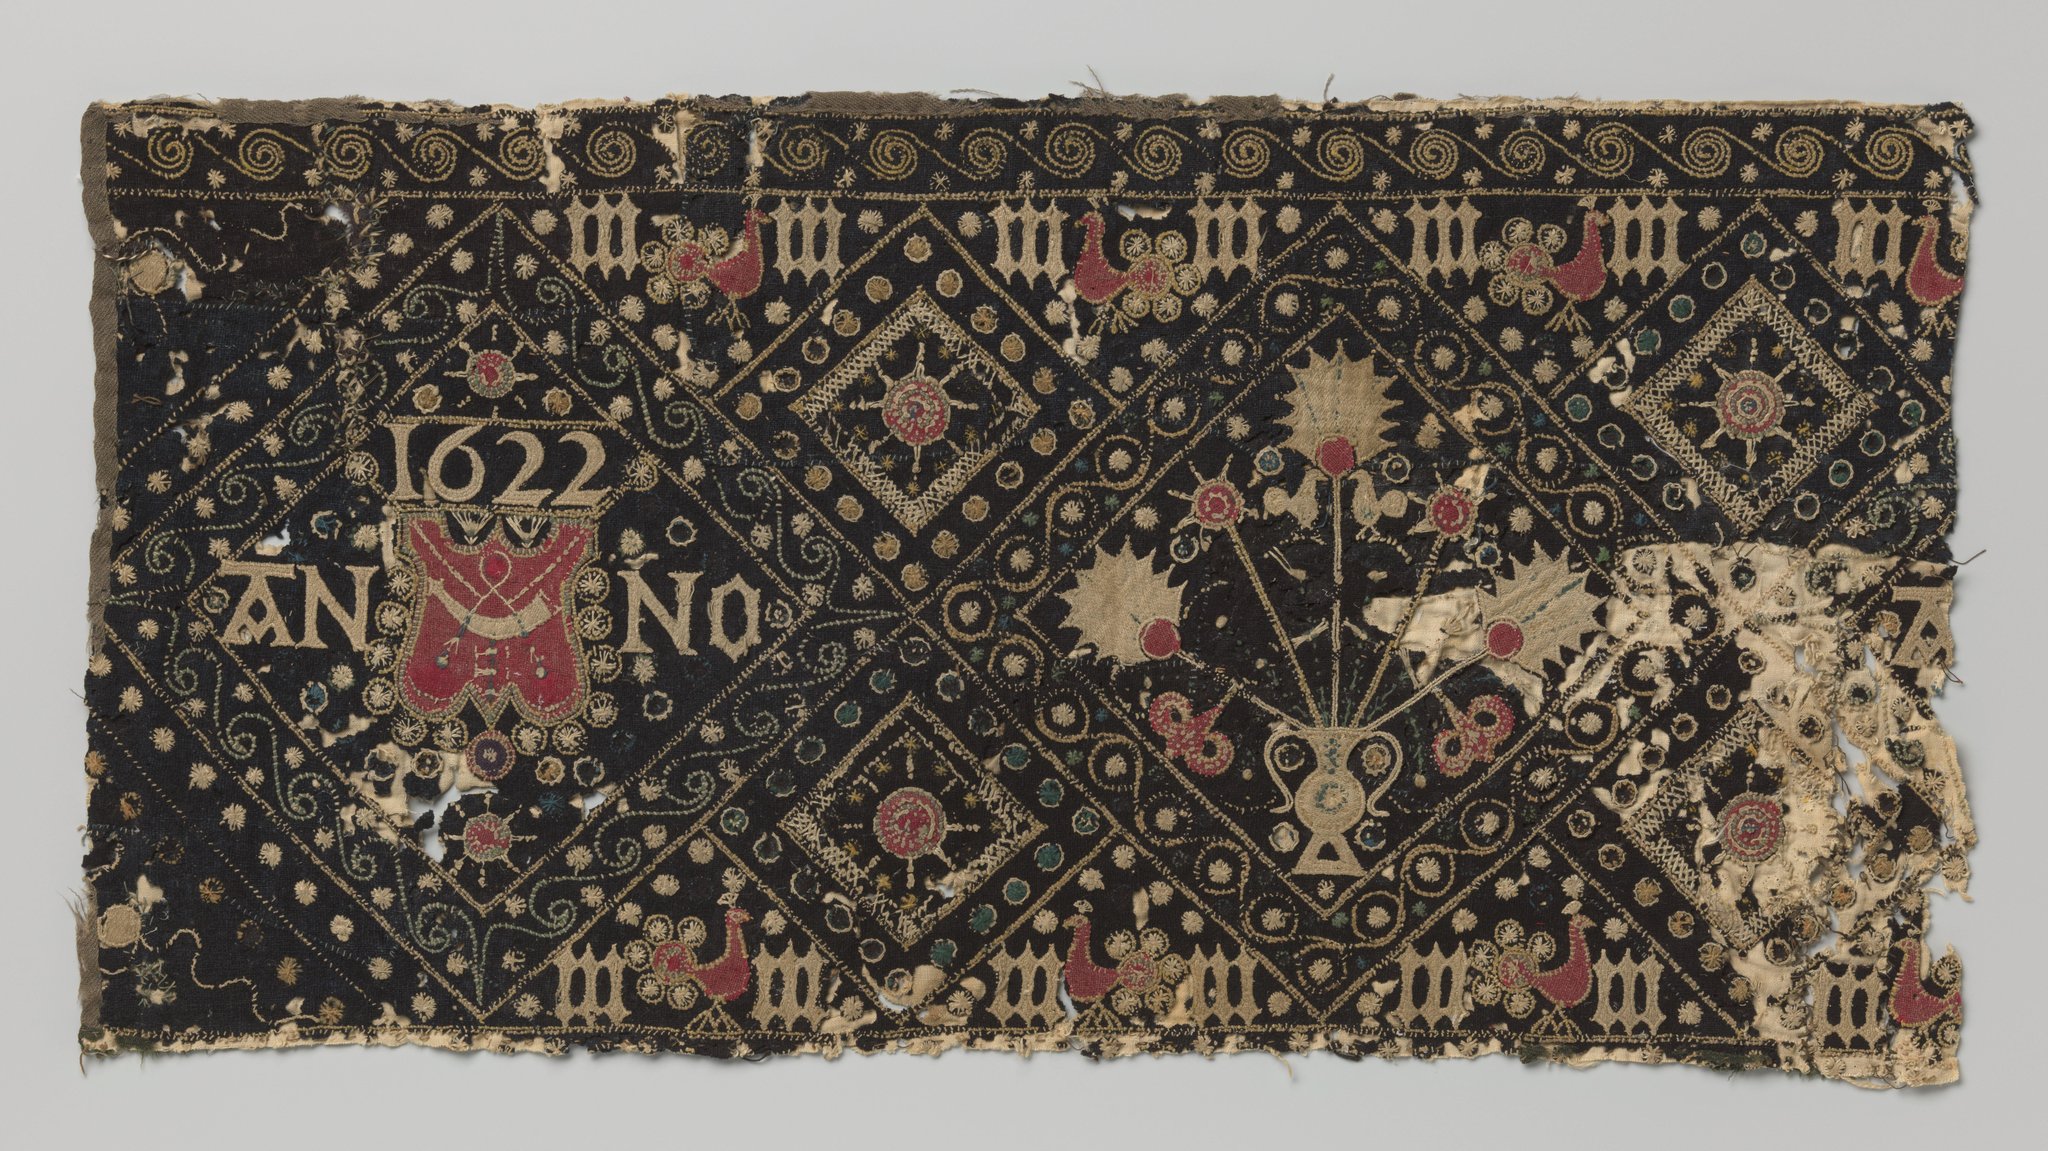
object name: funeral pall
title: Doopkleed of baarkleed van borduurwerk op donkerblauwe stof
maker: Anonymous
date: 1622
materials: cotton, wool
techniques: embroidered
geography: europe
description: Doopkleed of baarkleed van twee aaneengenaaide lappen donkerblauwe stof waarop een wapen is geborduurd met een jachthoorn, het jaartal ANNO 1622 en enige malen een gotische letter M. Mogelijk kerkelijk textiel.